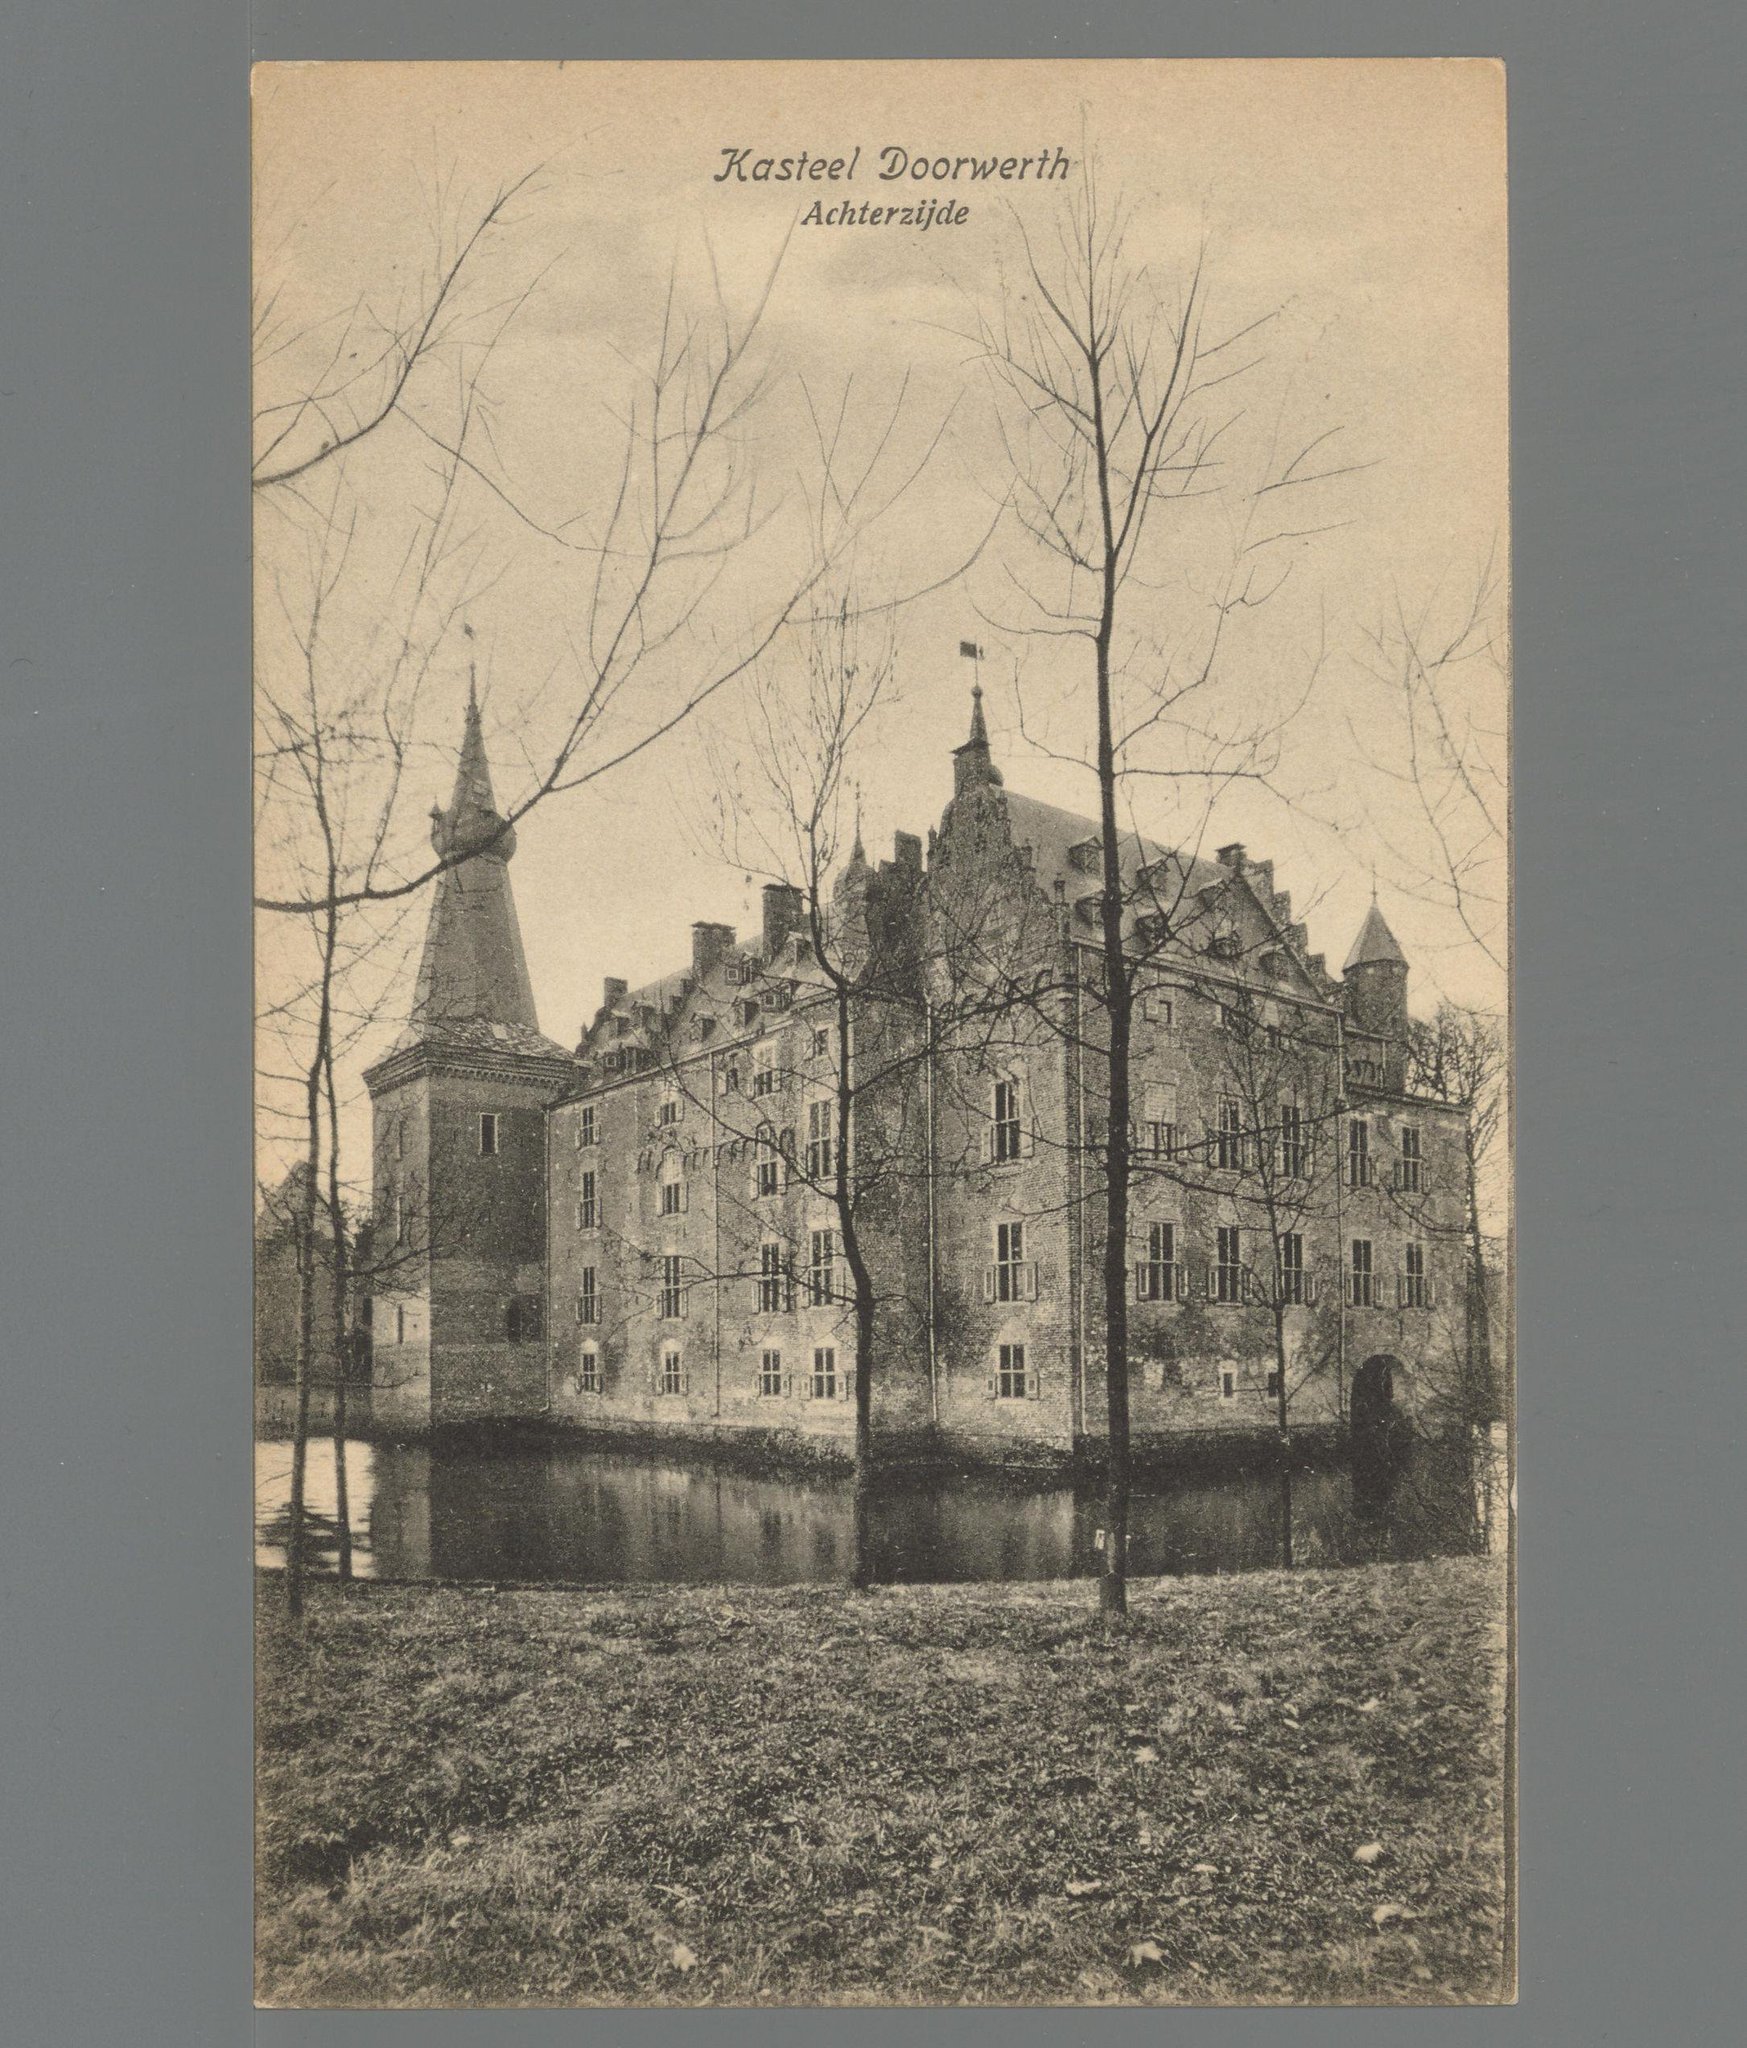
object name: photomechanical print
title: Kasteel Doorwerth. Achterzijde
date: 1916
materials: cardboard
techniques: photograph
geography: doorwerth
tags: castle, canal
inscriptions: date